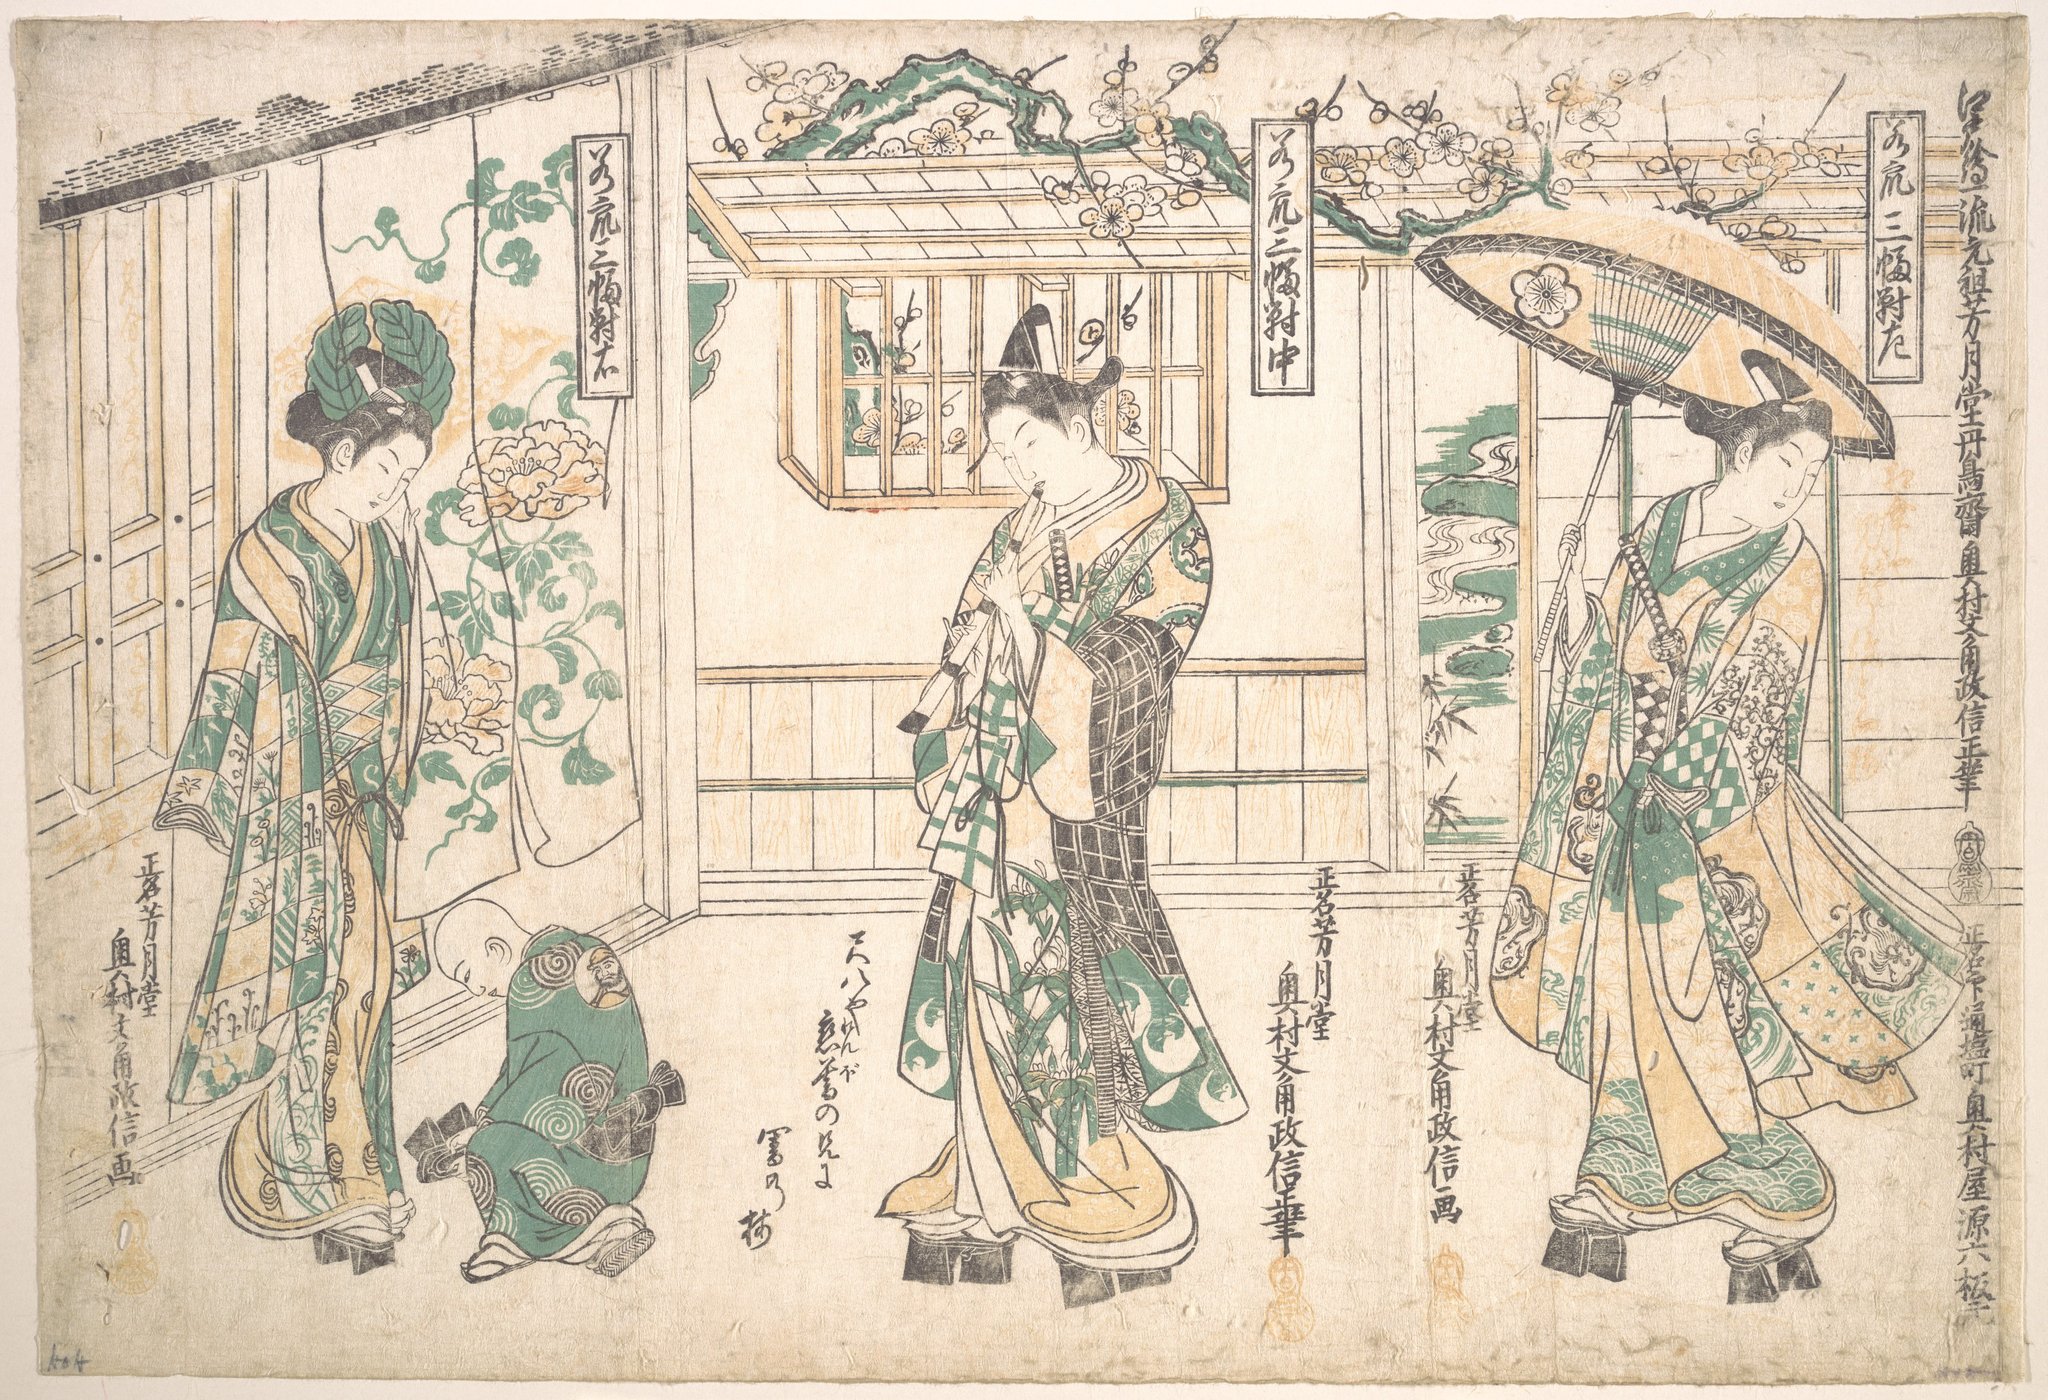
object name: print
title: Tripytych of Young Men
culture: japanese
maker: okumura masanobu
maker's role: artist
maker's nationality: japanese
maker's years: 1686-1764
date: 1691-1768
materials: ink, paper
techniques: woodblock print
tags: men,women,flowers